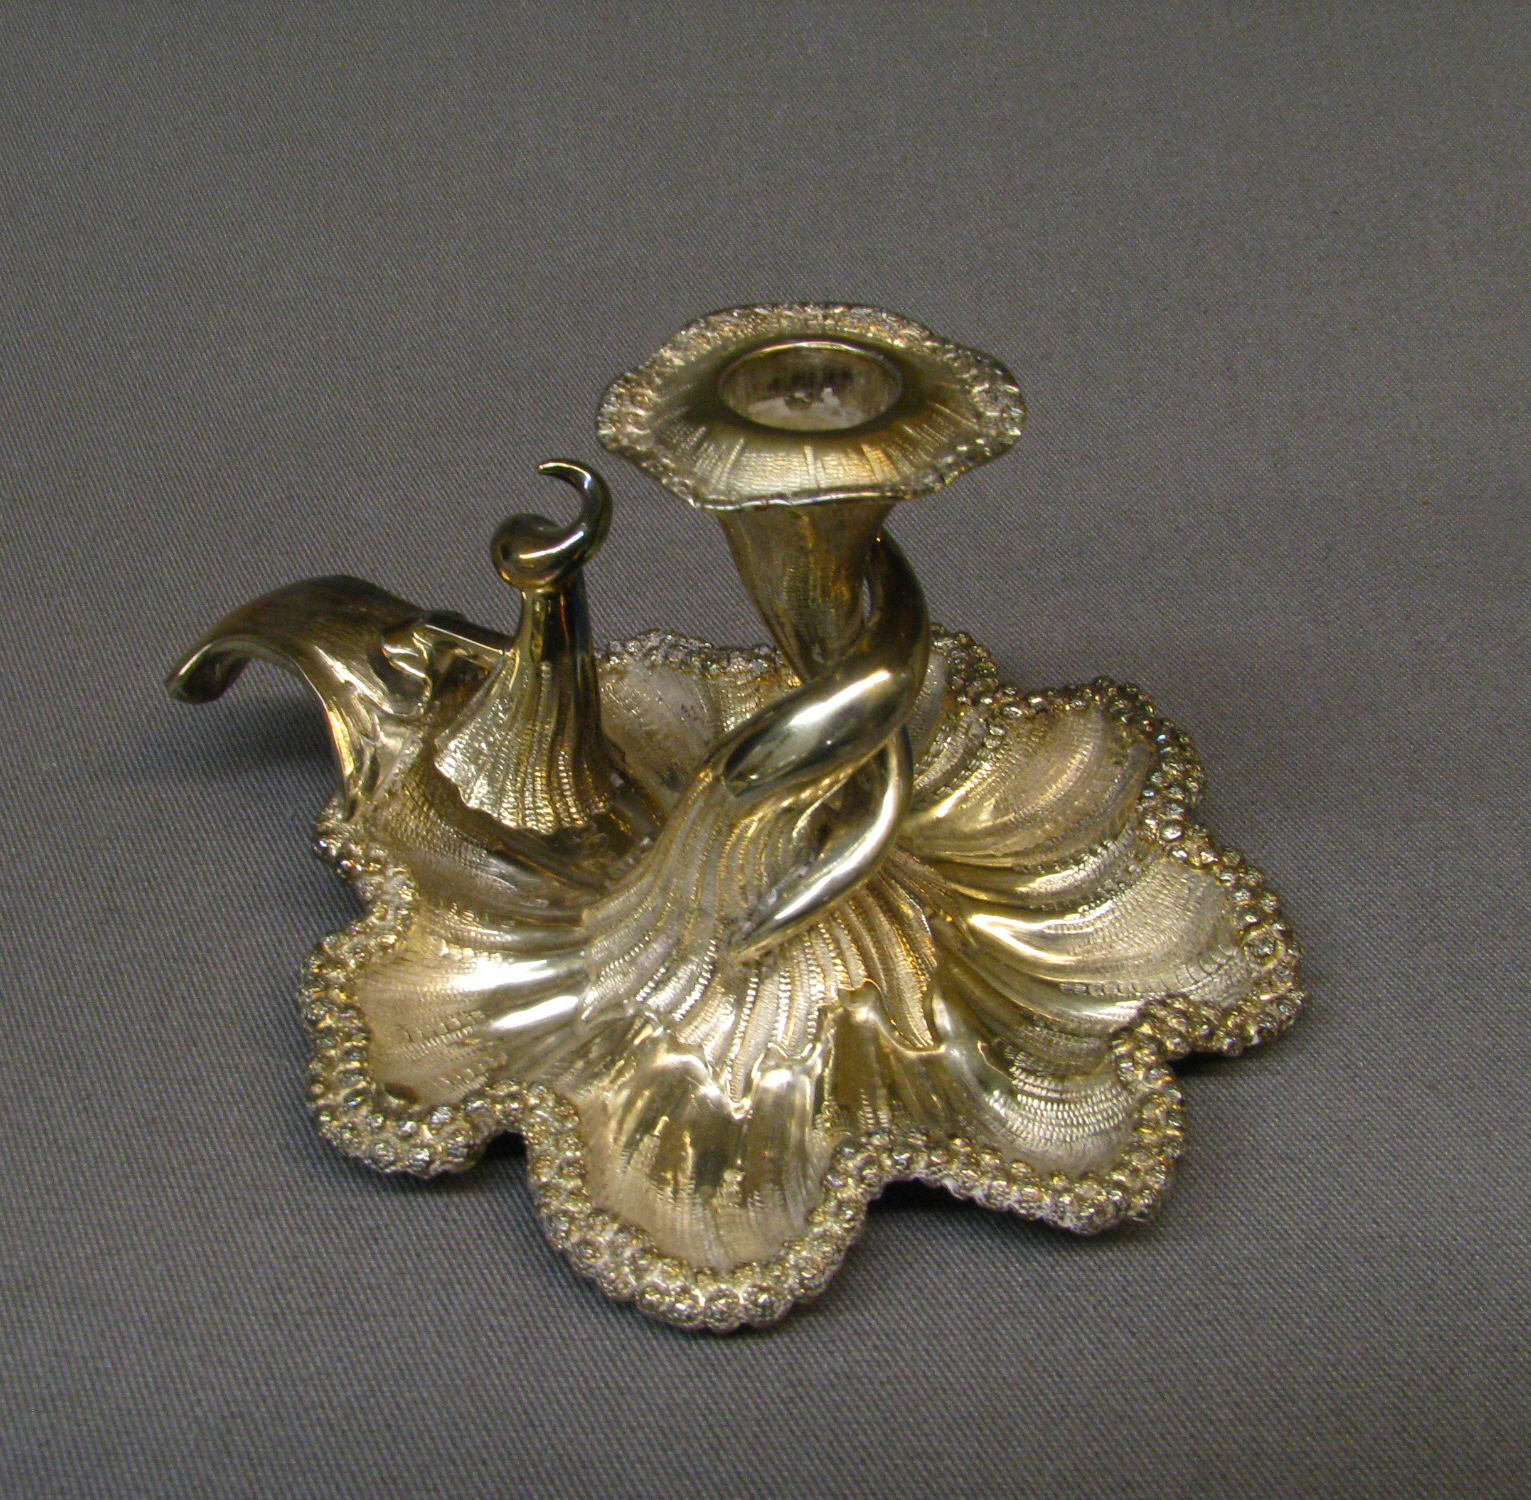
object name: chamber candlestick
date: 1846-1847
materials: silver